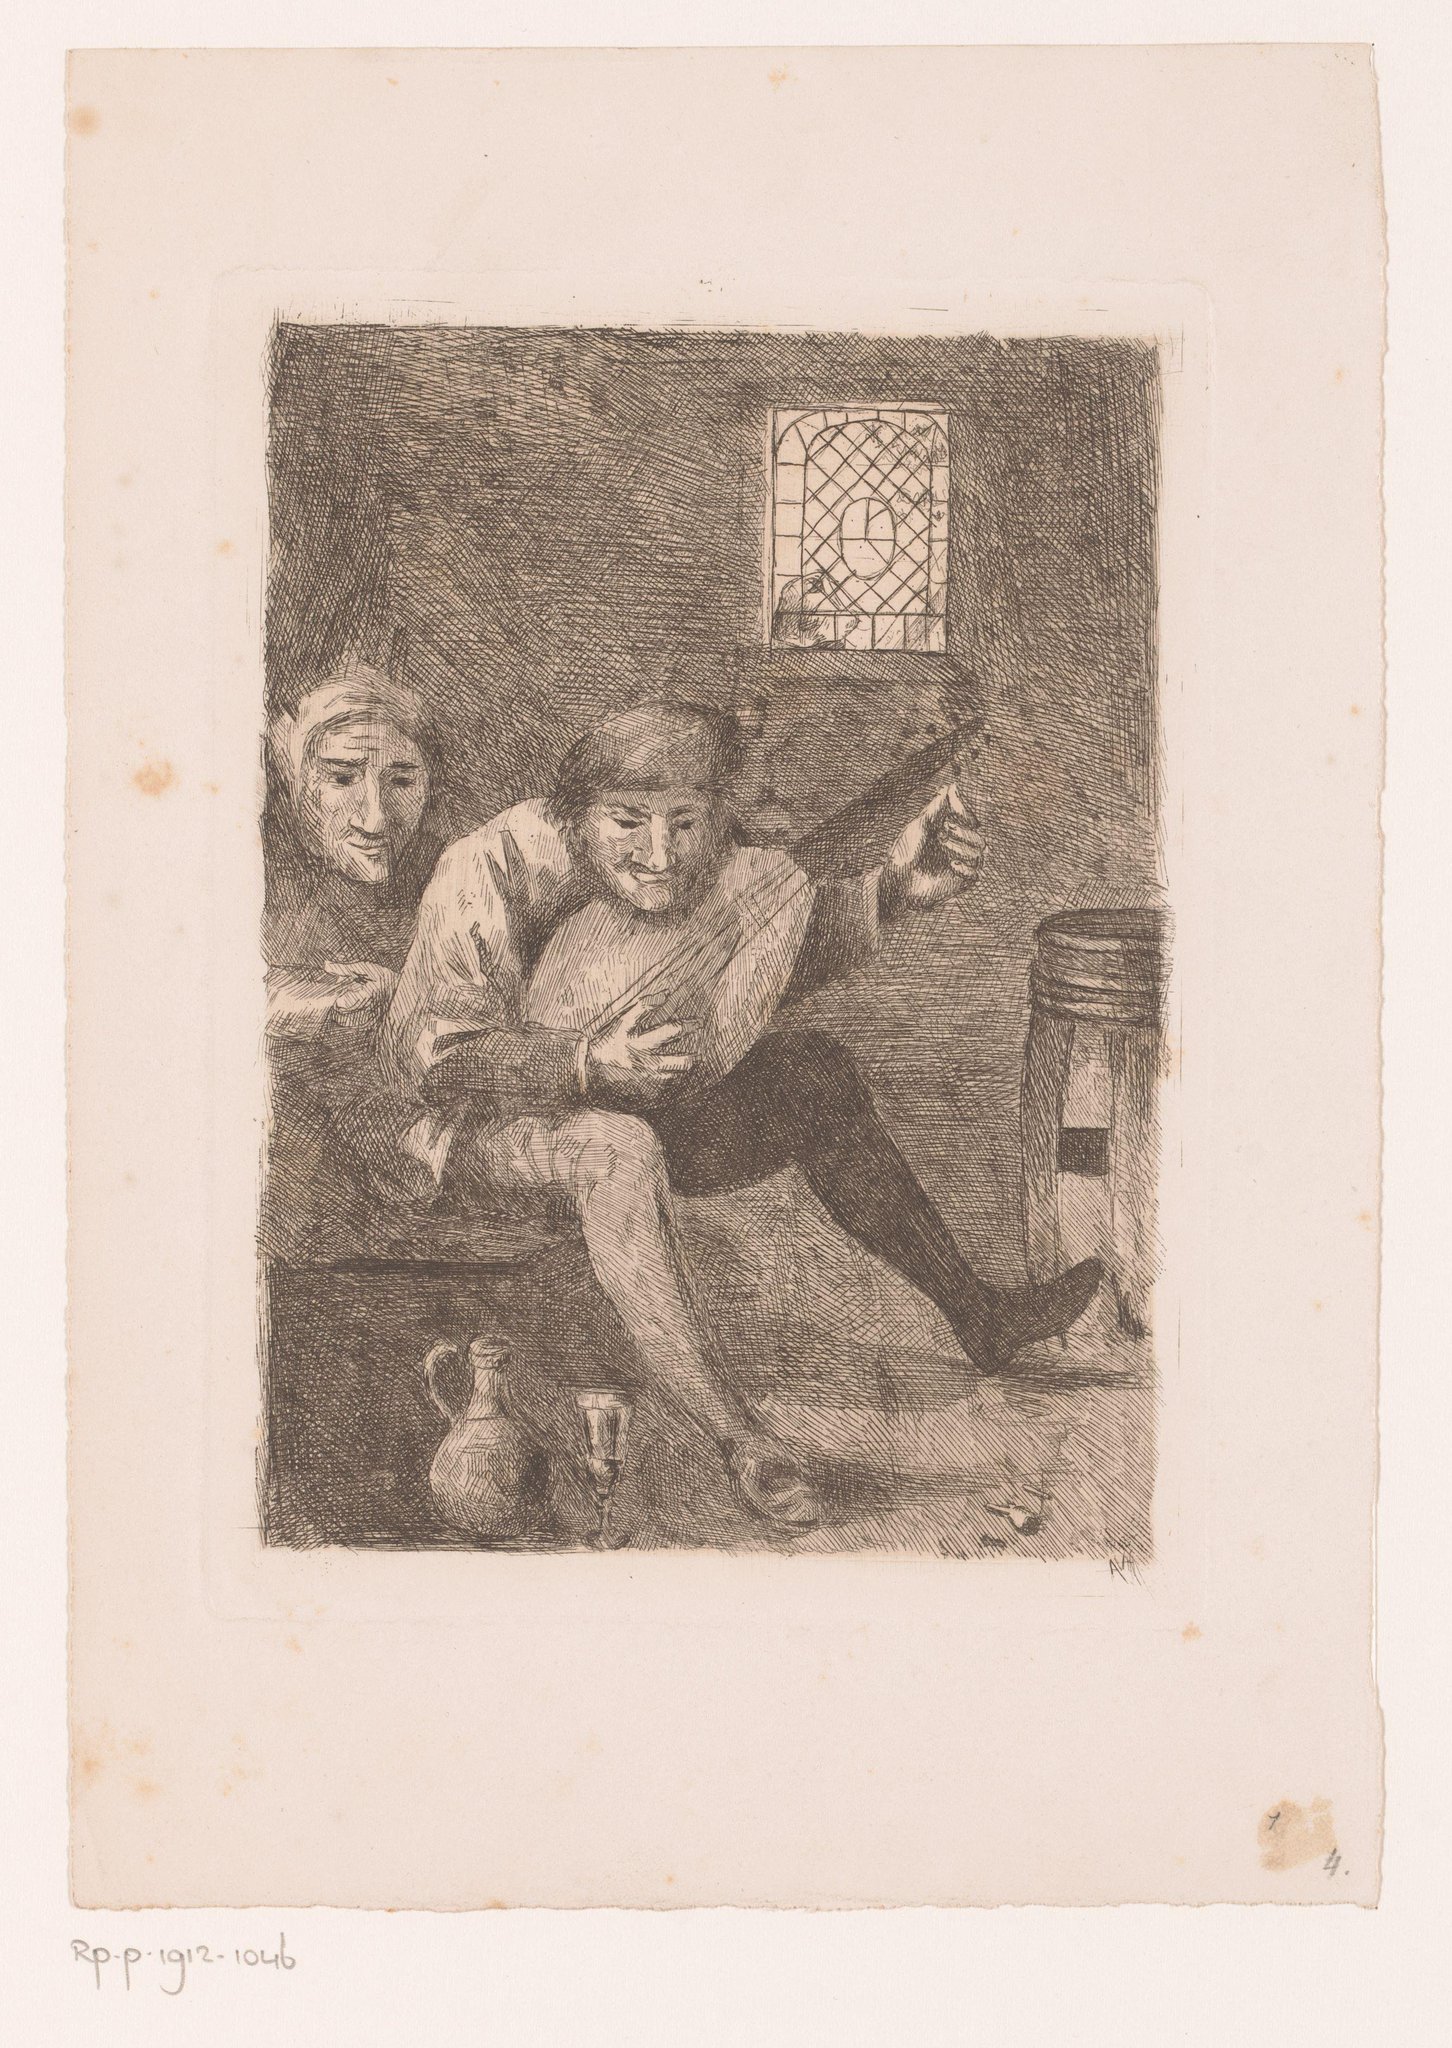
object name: print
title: Luitspeler stemt zijn instrument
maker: albert van holsbeeck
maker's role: print maker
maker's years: 1877-1948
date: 1887-1912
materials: paper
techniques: etching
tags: tuning the lute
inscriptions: collector's mark: Lugt 2228